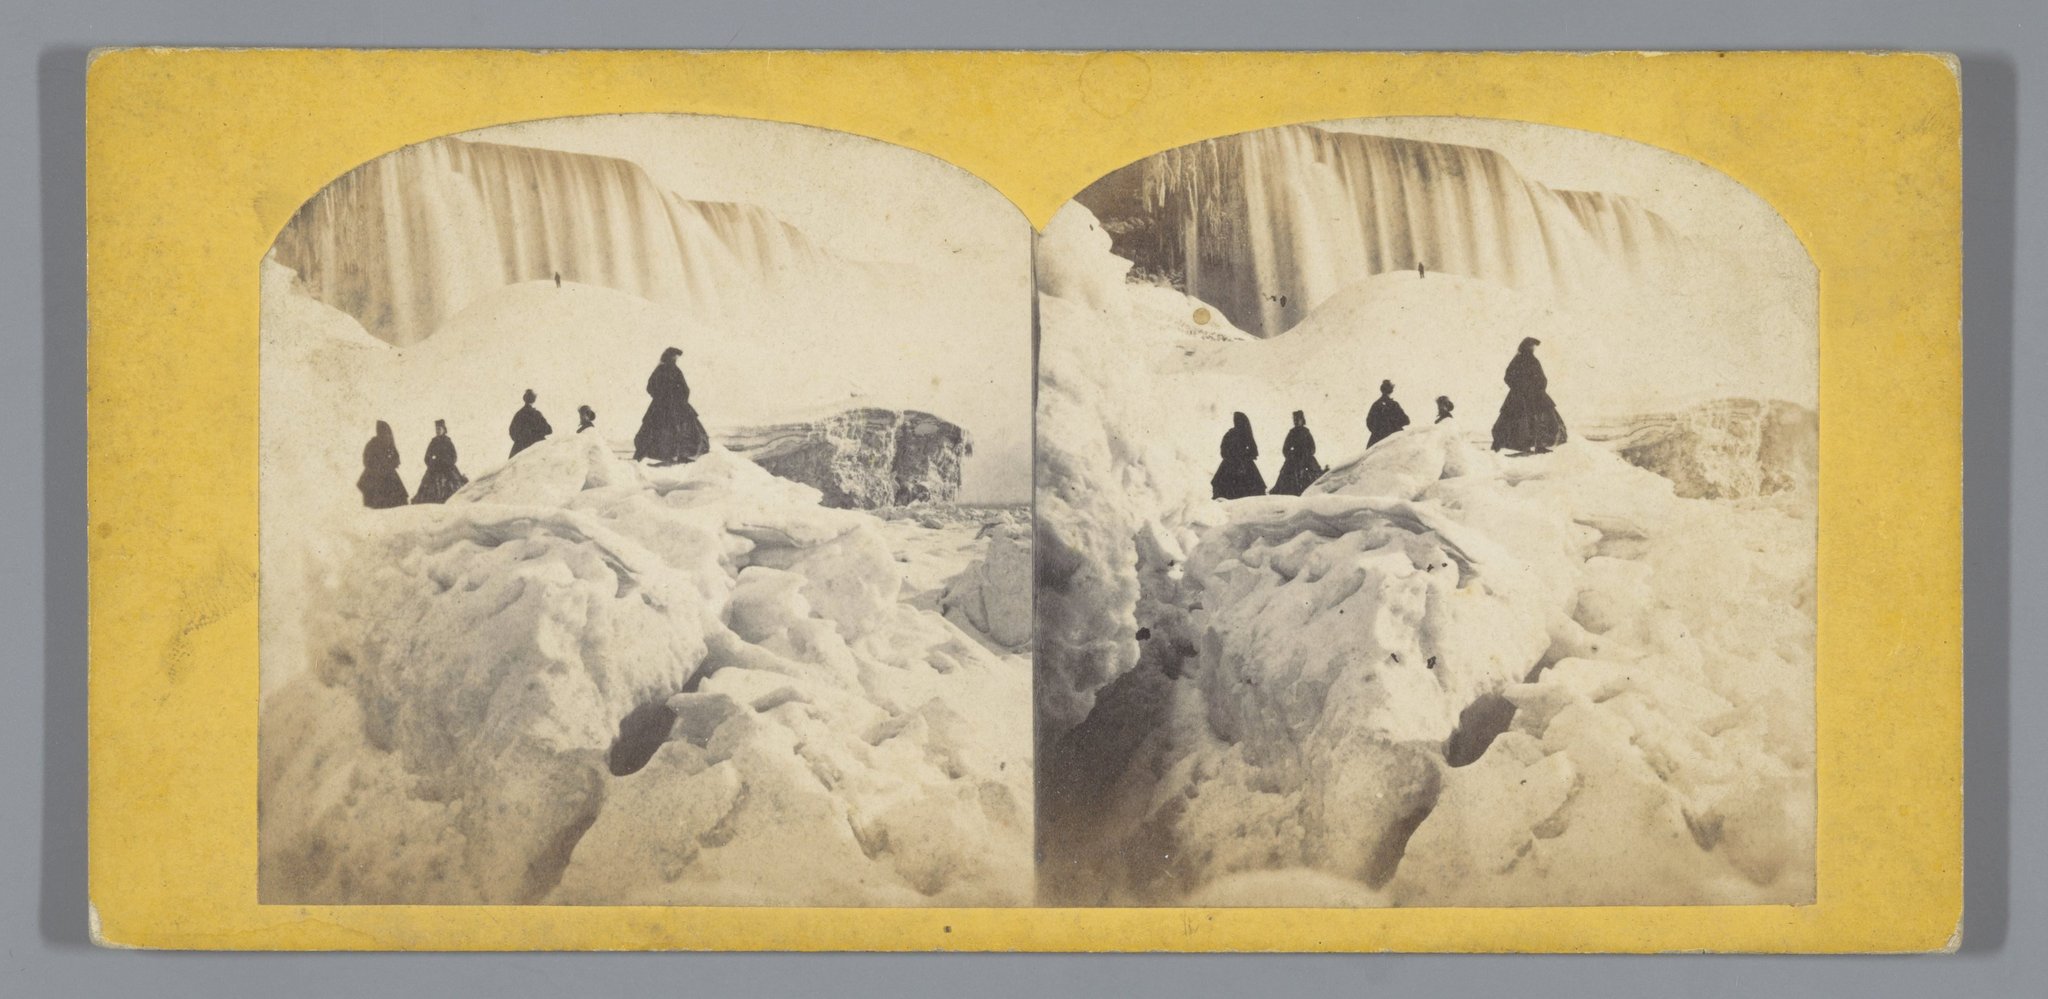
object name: stereograph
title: The Great Ice Bridge and American Falls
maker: Anonymous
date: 1868-1890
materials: cardboard, paper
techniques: albumen print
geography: niagara falls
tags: waterfall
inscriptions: number: ‘No 123.’, title: ‘The Great Ice Bridge &/ American Falls.’